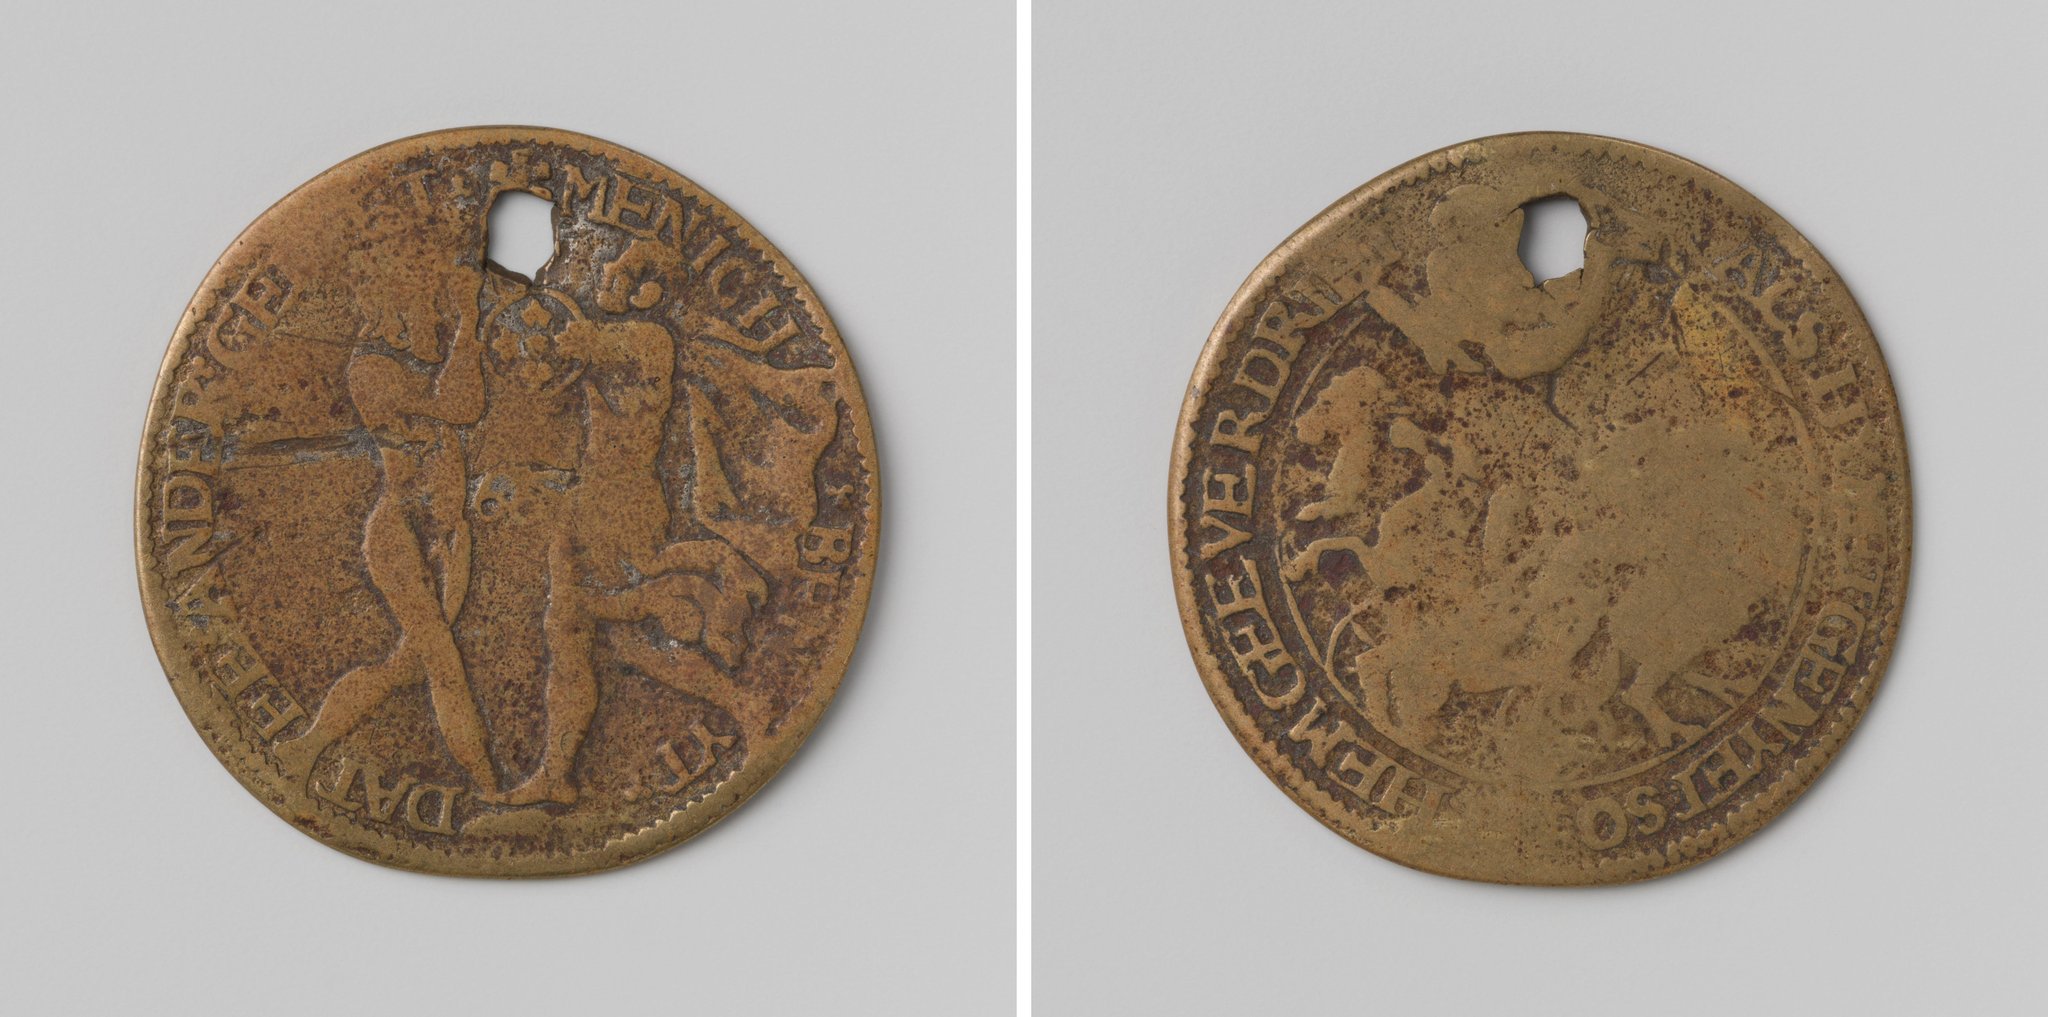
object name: jeton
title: Compromis der Edelen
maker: Anonymous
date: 1566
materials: brass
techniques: striking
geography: netherlands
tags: verbond der edelen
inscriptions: inscription: ‘(rozet) MENICH - (drieblad) BEN - YT (drieblad) DAT - EE (drieblad) ANDER (drieblad) GENIET (drieblad) / 66’, inscription: ‘ALS HY (ME)T GENYET SO (IST) HEM GEE VERDRIET’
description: messing penning met gat erin. Voorzijde: naakte, ongewapende man, vechtend tegen man met mantel en schild binnen omschrift. Keerzijde: Jupiter werpt met bliksem Phaeton uit zonnewagen binnen omschrift